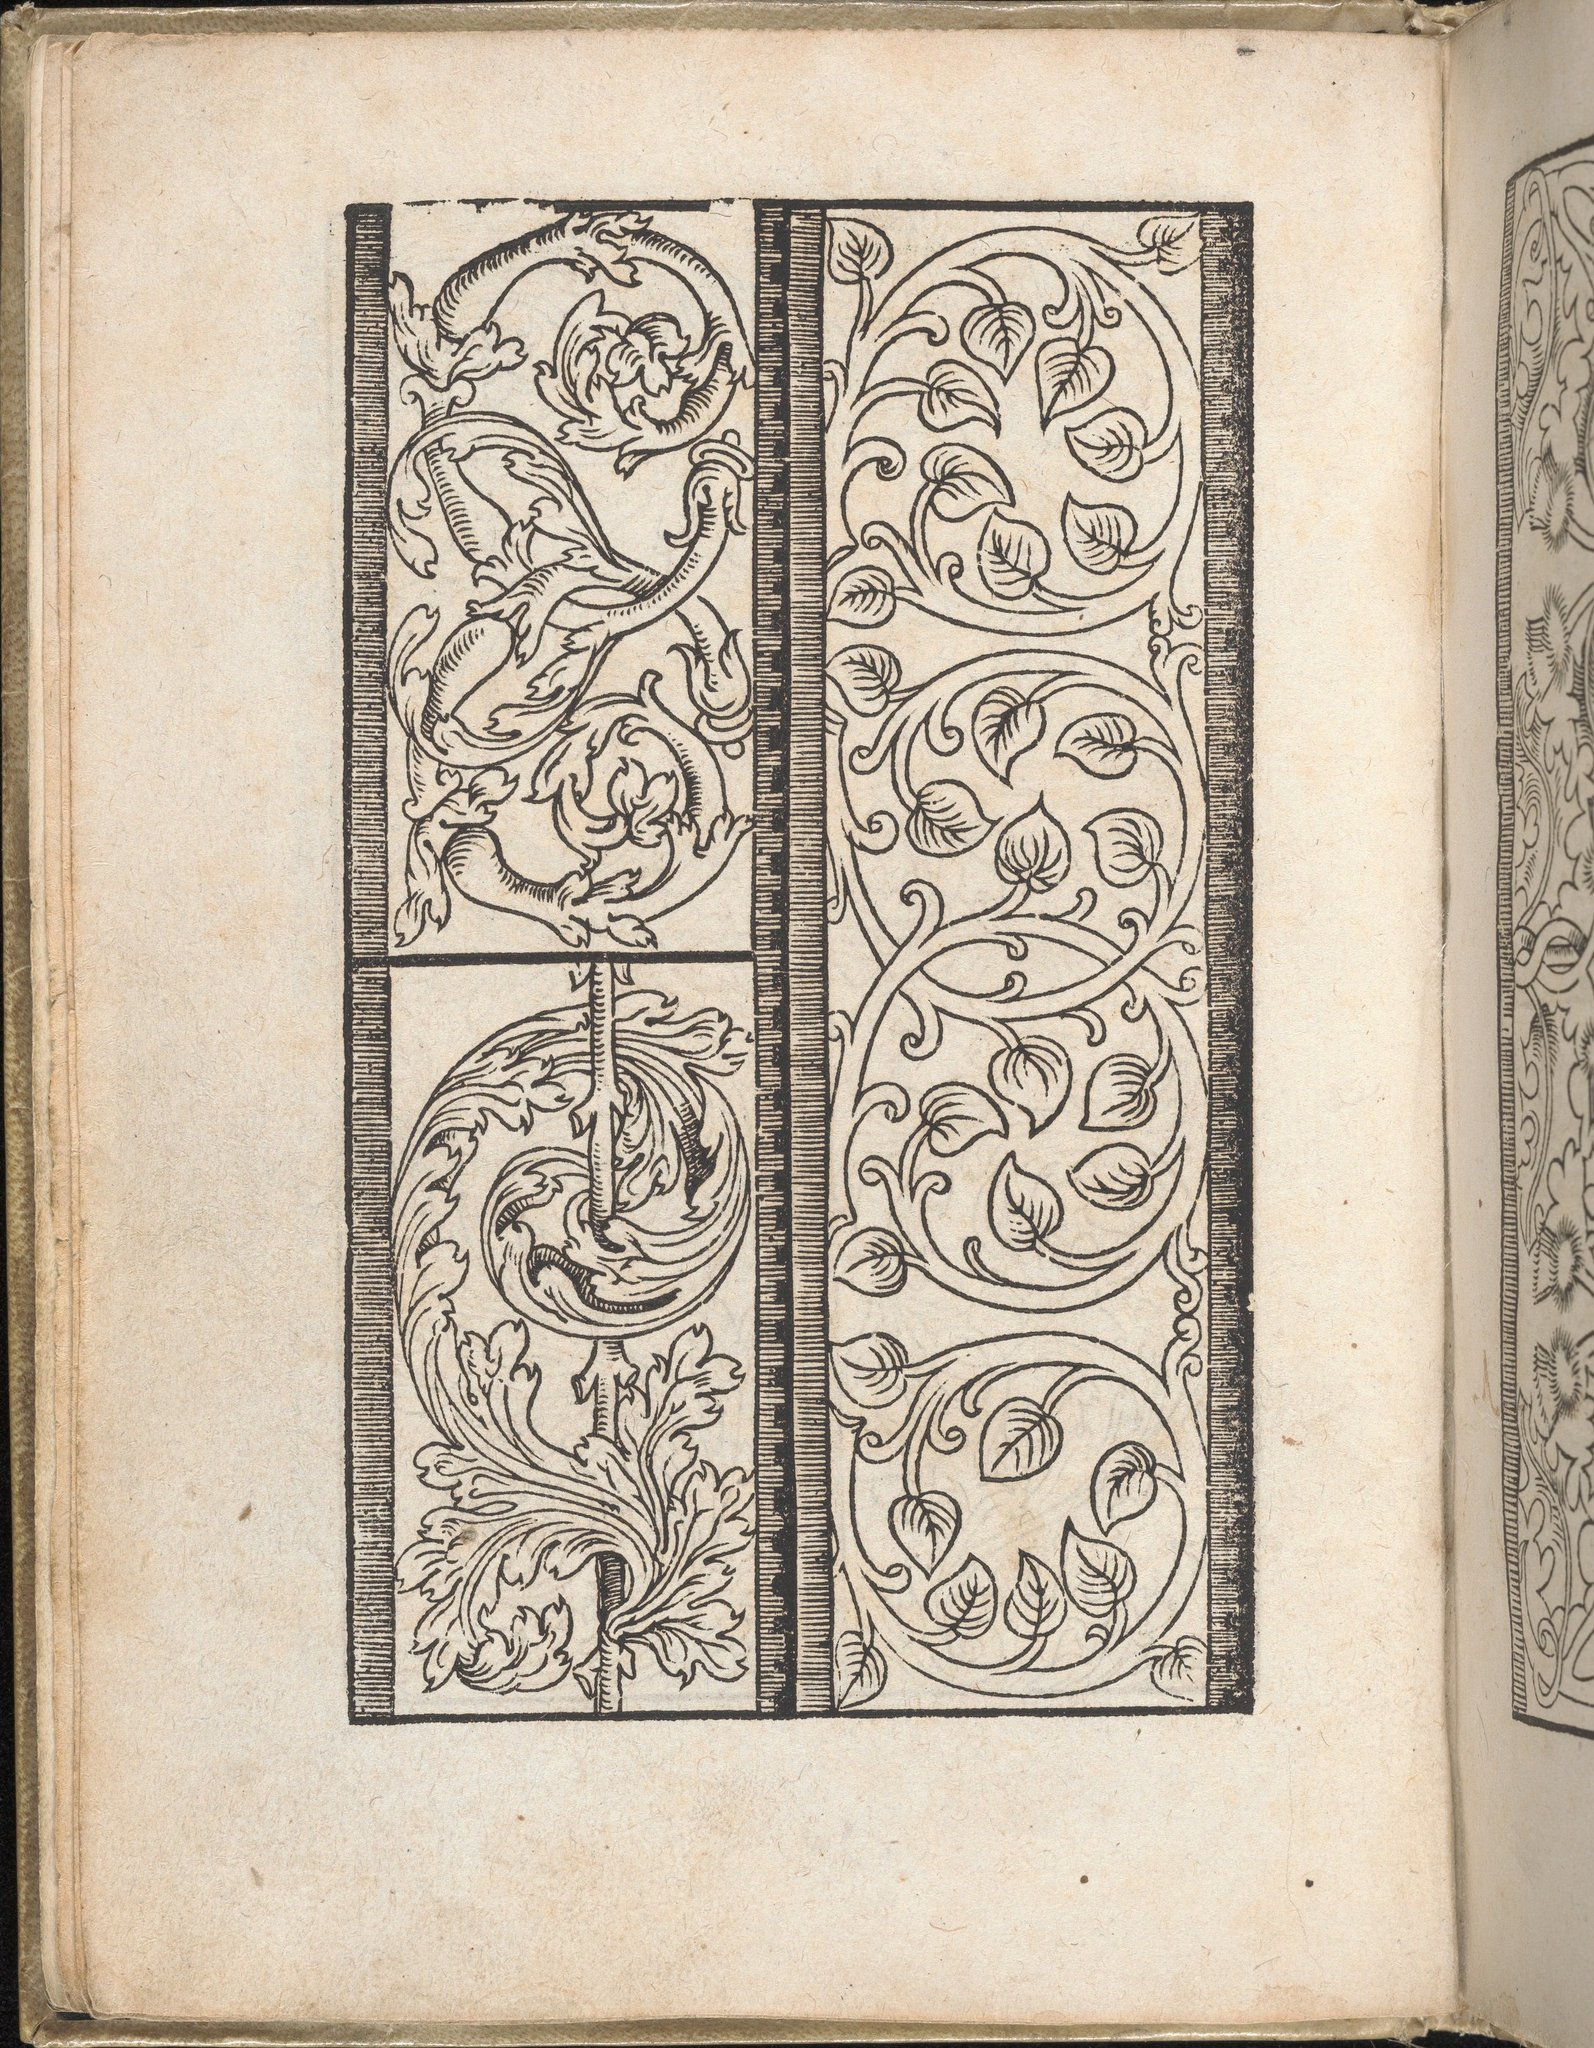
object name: book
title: Page 5r, from "Eyn New Kunstlichboich"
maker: peter quentel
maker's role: publisher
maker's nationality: german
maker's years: 1500-1550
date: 1529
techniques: woodcut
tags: ornament